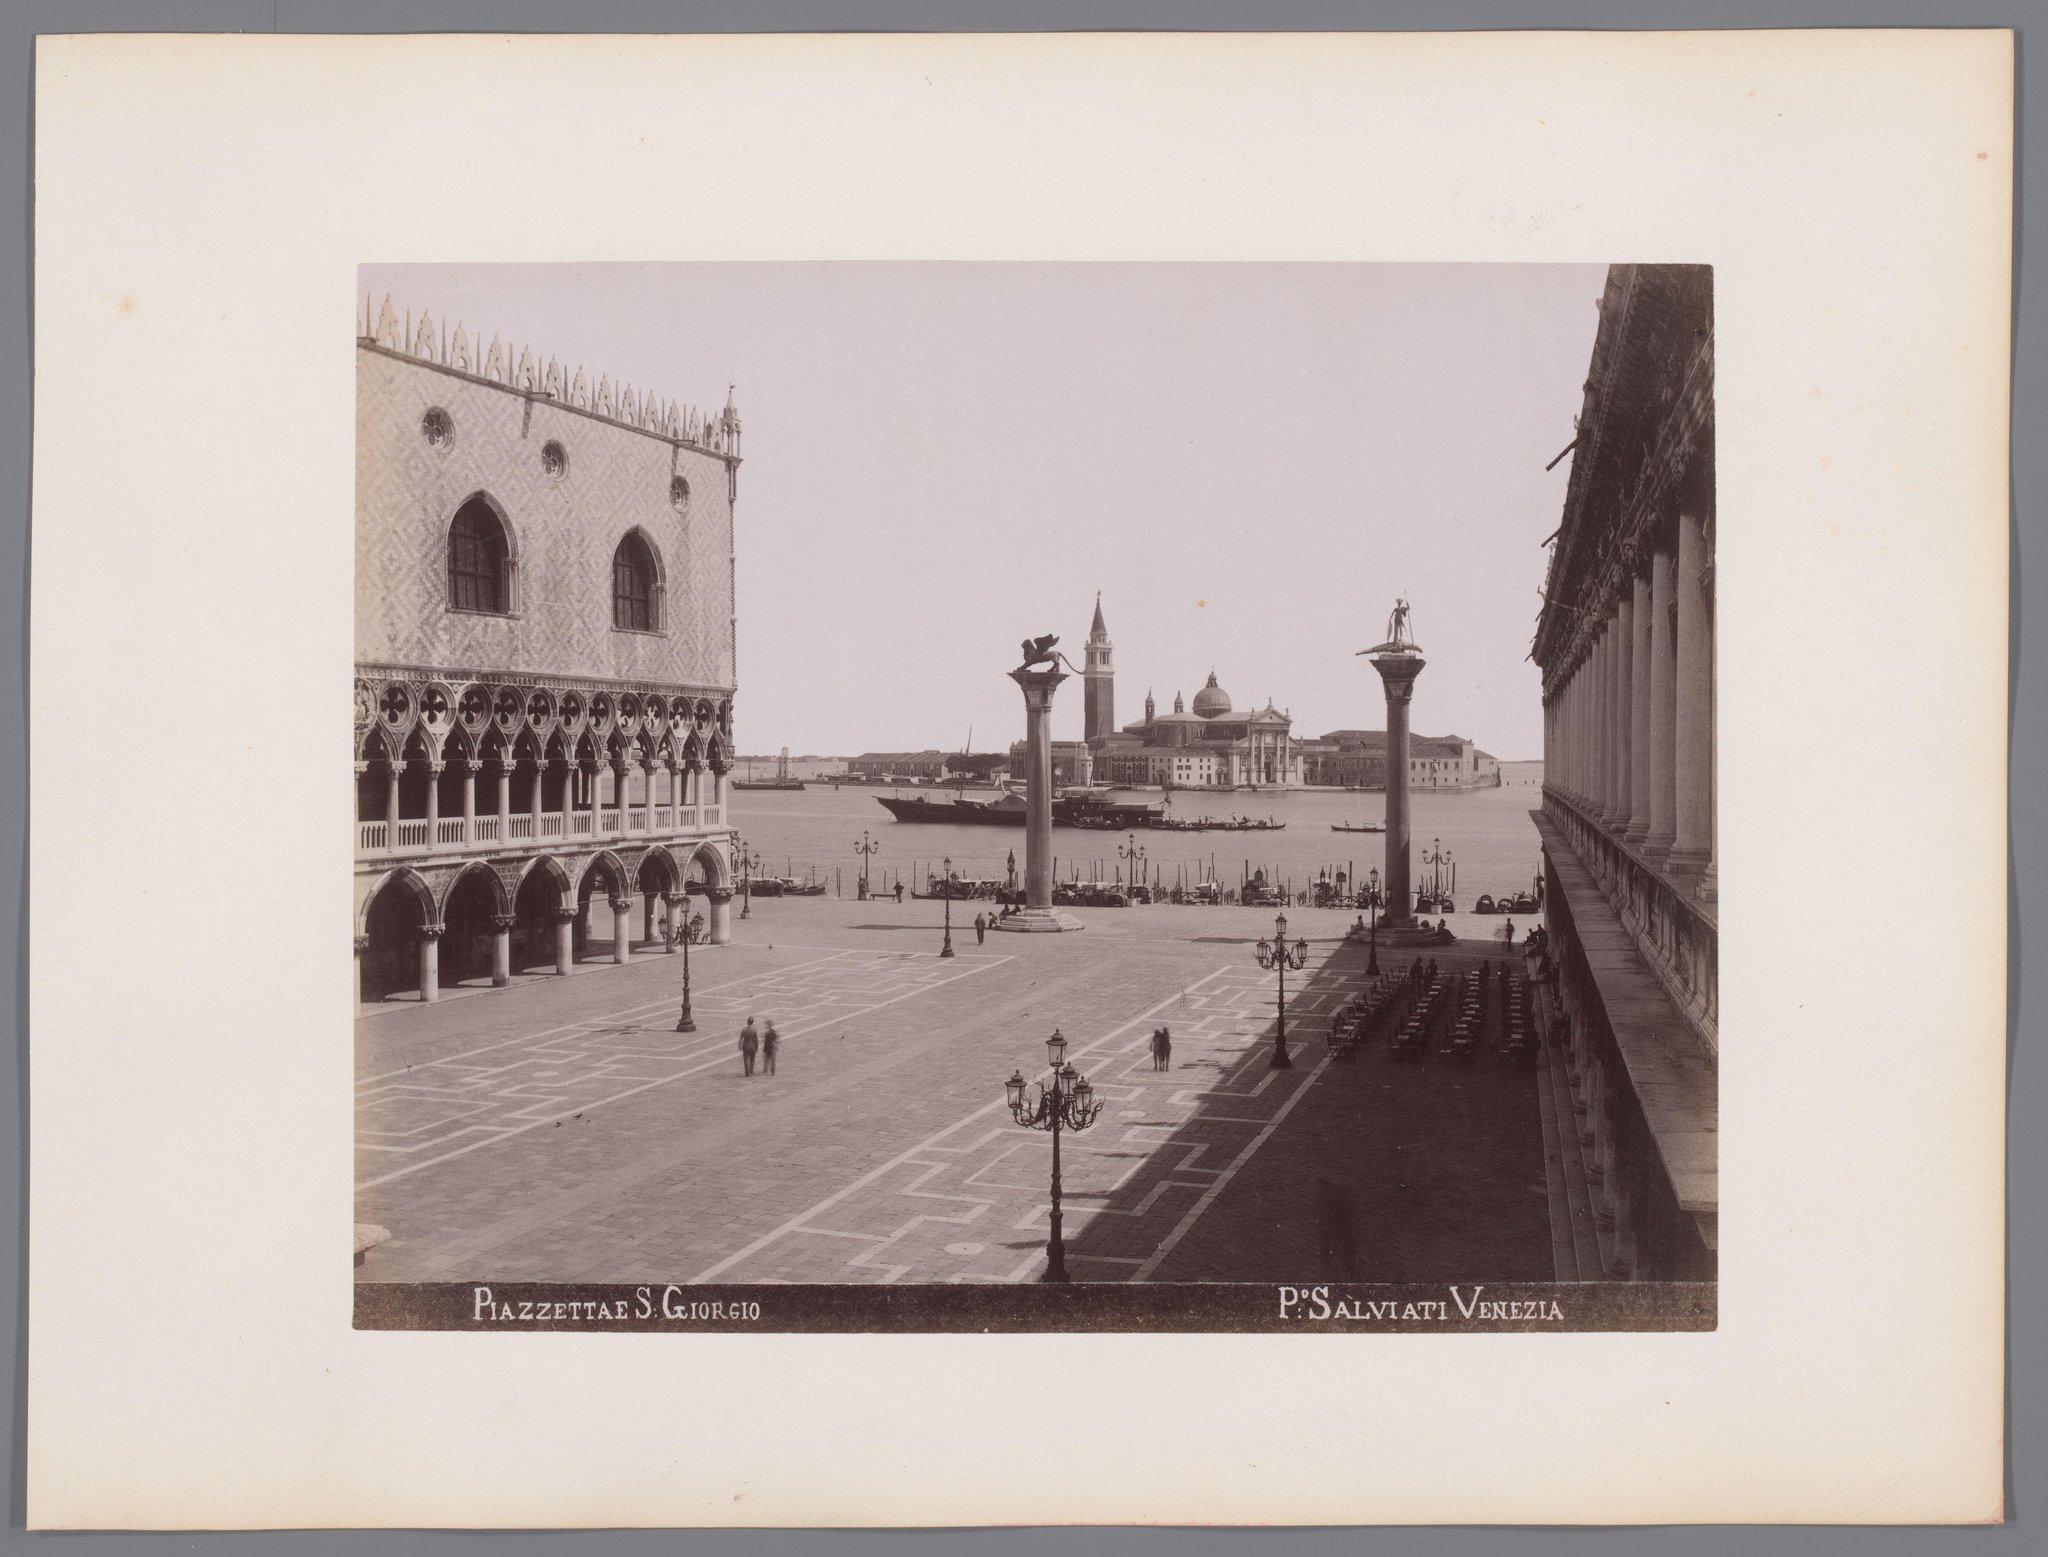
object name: photograph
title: Piazzettae S. Giorgio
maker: paolo salviati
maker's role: fotograaf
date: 1860-1870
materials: cardboard, paper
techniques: albumen print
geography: venice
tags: square, place, circus, etc., city-view in general; 'veduta'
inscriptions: inscription: ‘Venetie’